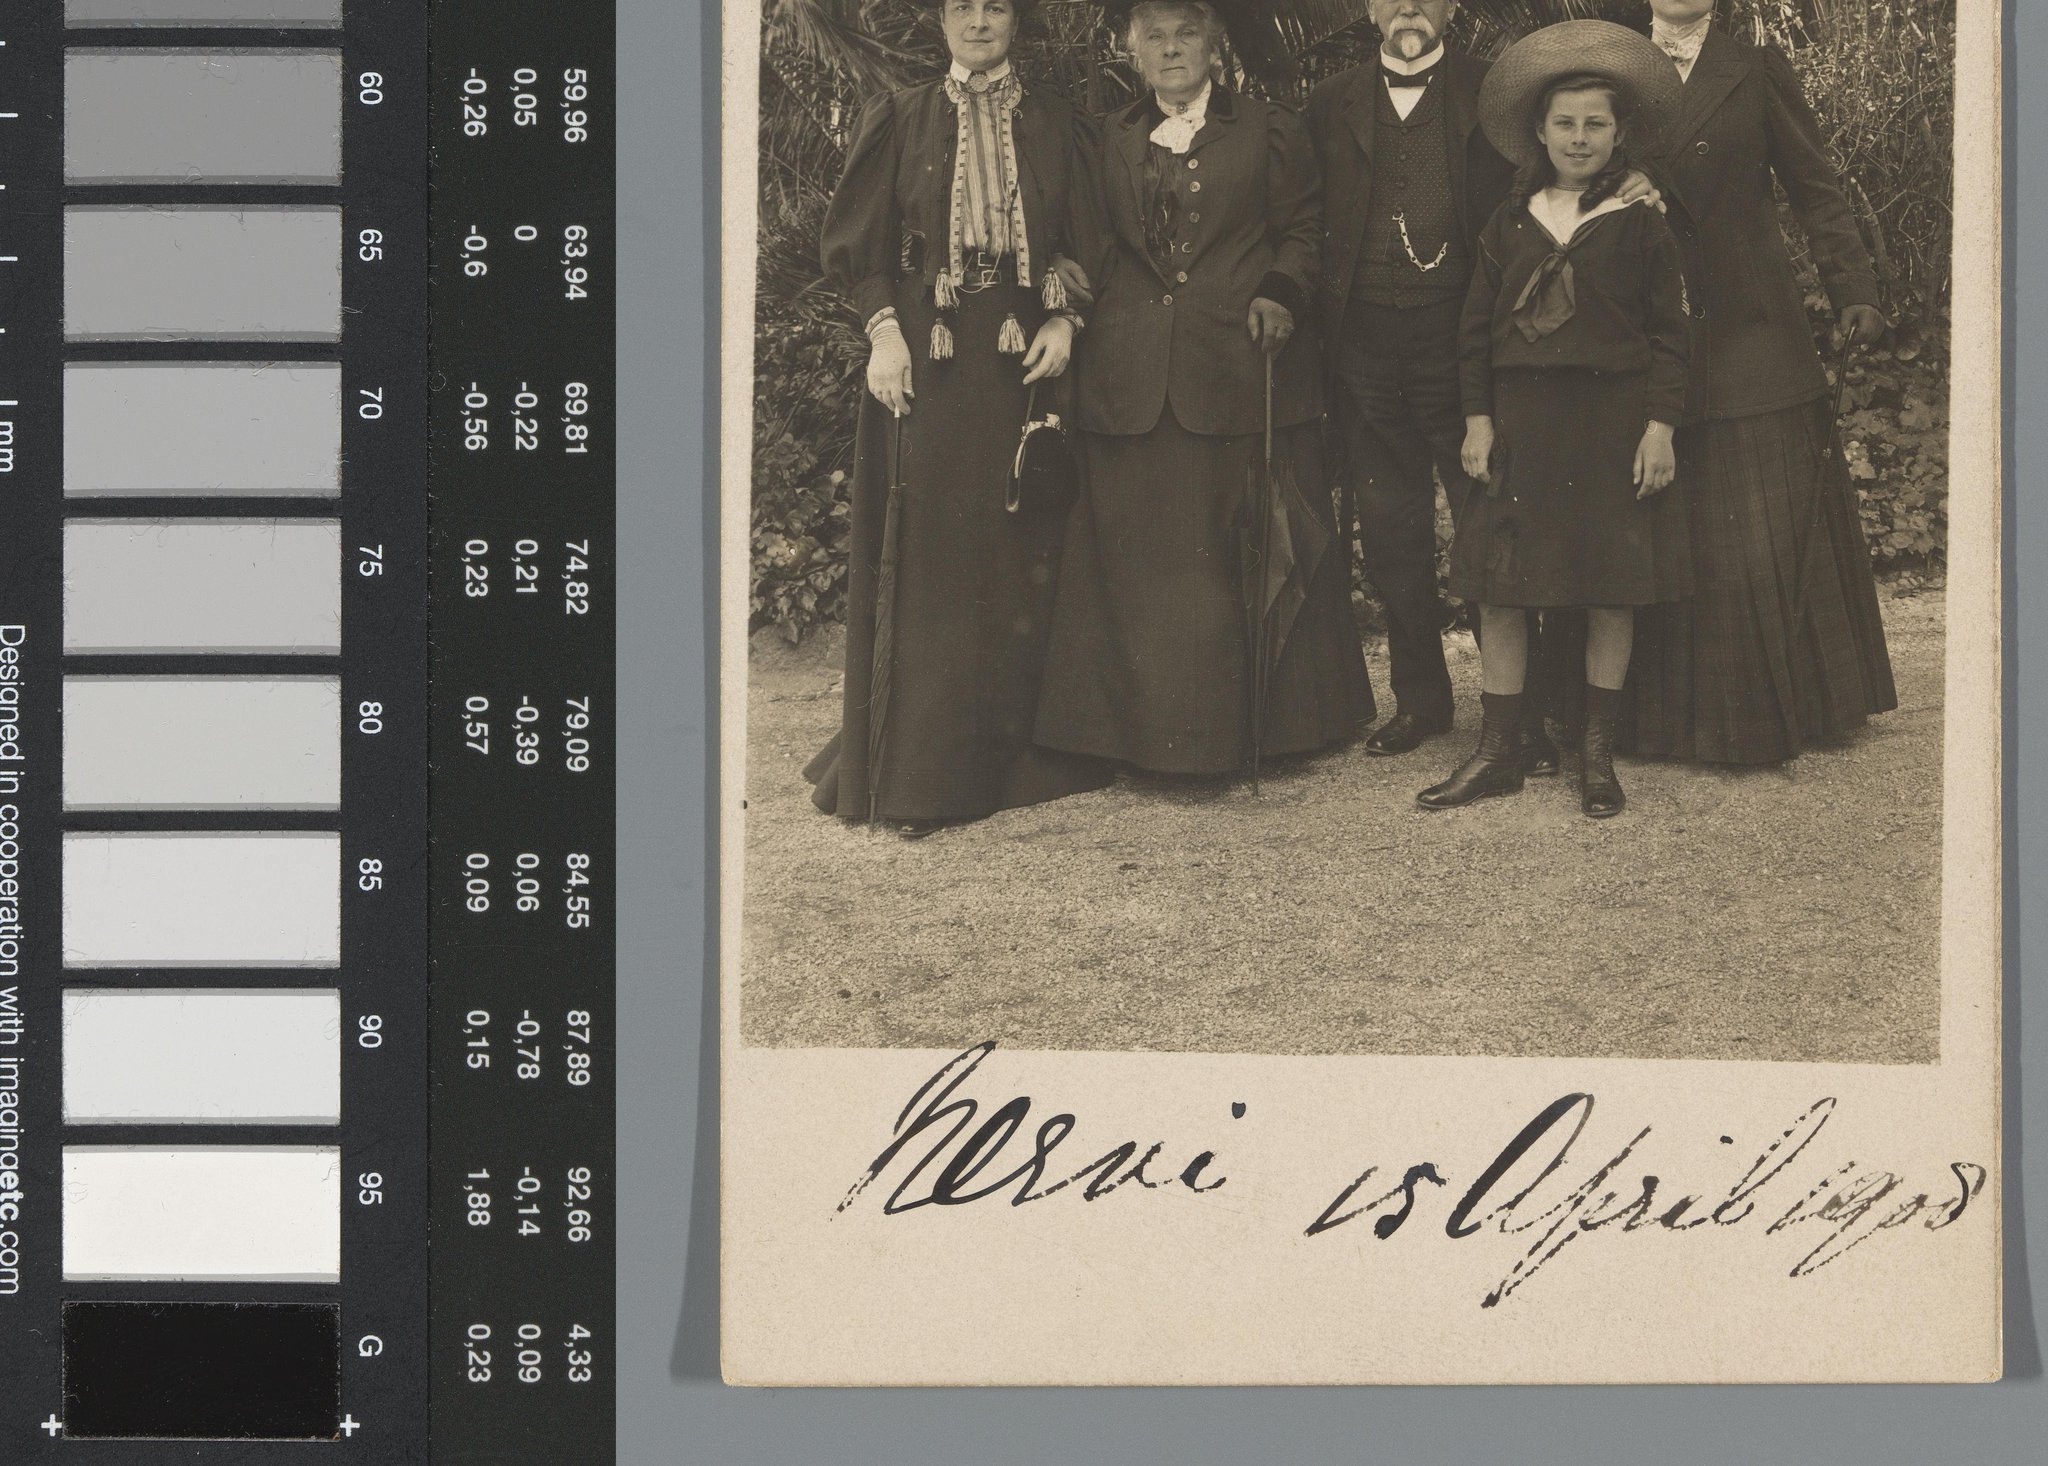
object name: ansichtkaart, prentbriefkaart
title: Groepsportret met vijf mensen in een tuin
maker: Anonymous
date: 1908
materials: photographic support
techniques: photography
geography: netherlands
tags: the hague, caroline louise van den berg-van den berg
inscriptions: inscription: ‘Jo Gijzelman / Line / 1901 / den Haag’, date: ‘.... 15 April 1908’